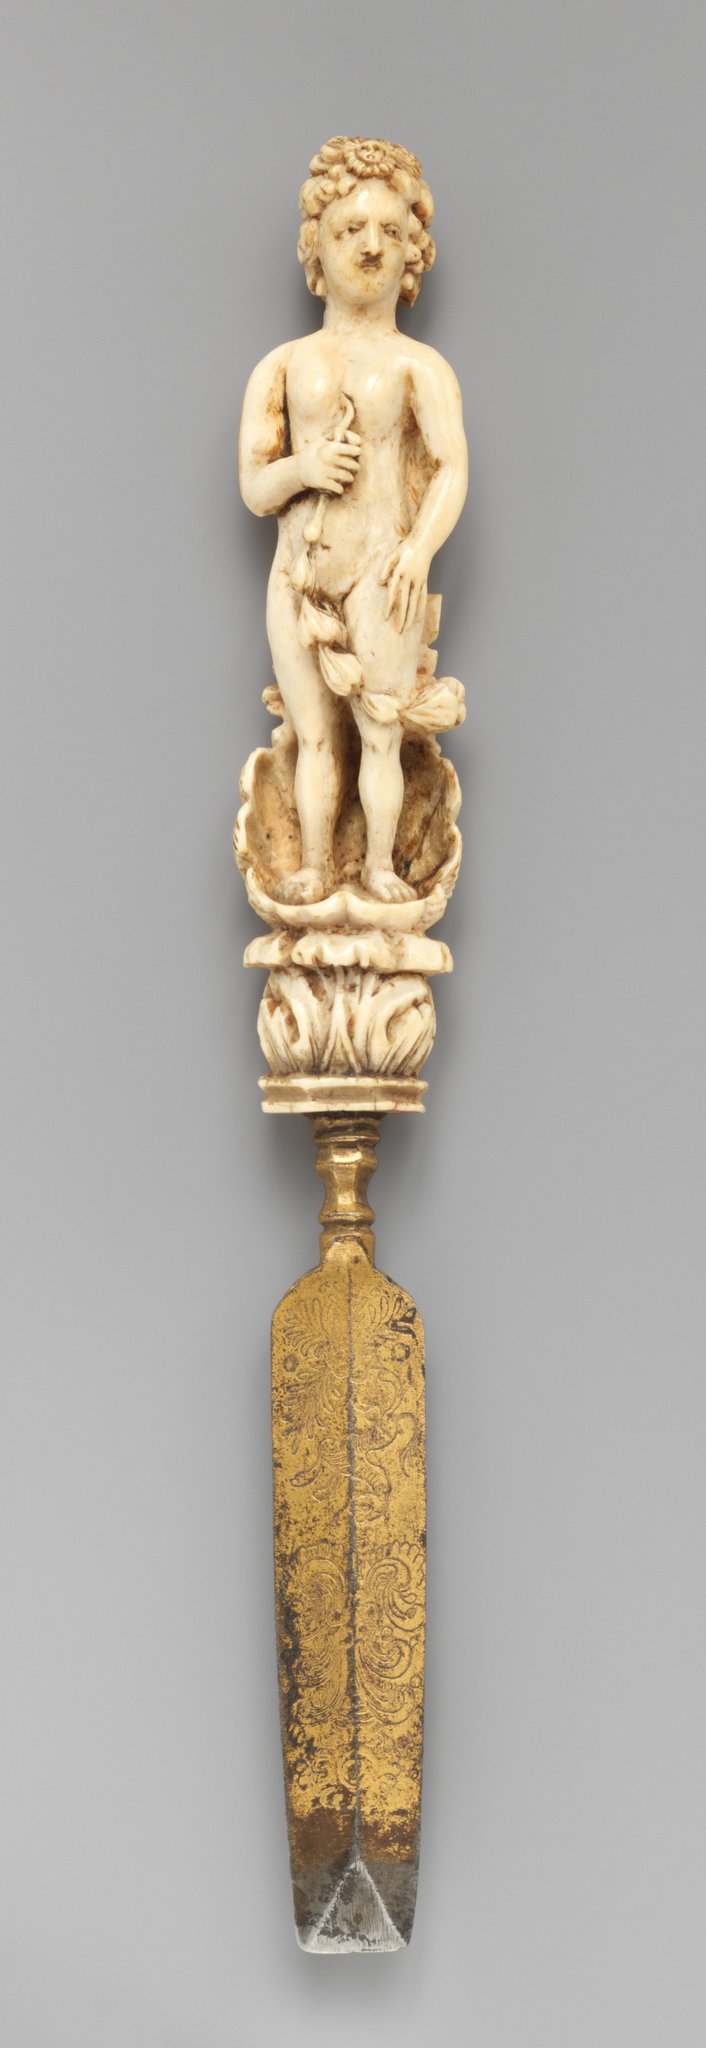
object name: paper knife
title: Paper knife with carved handle of nude with sun in hair standing in a half shell holding a swag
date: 1601-1650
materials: gilt, ivory, steel